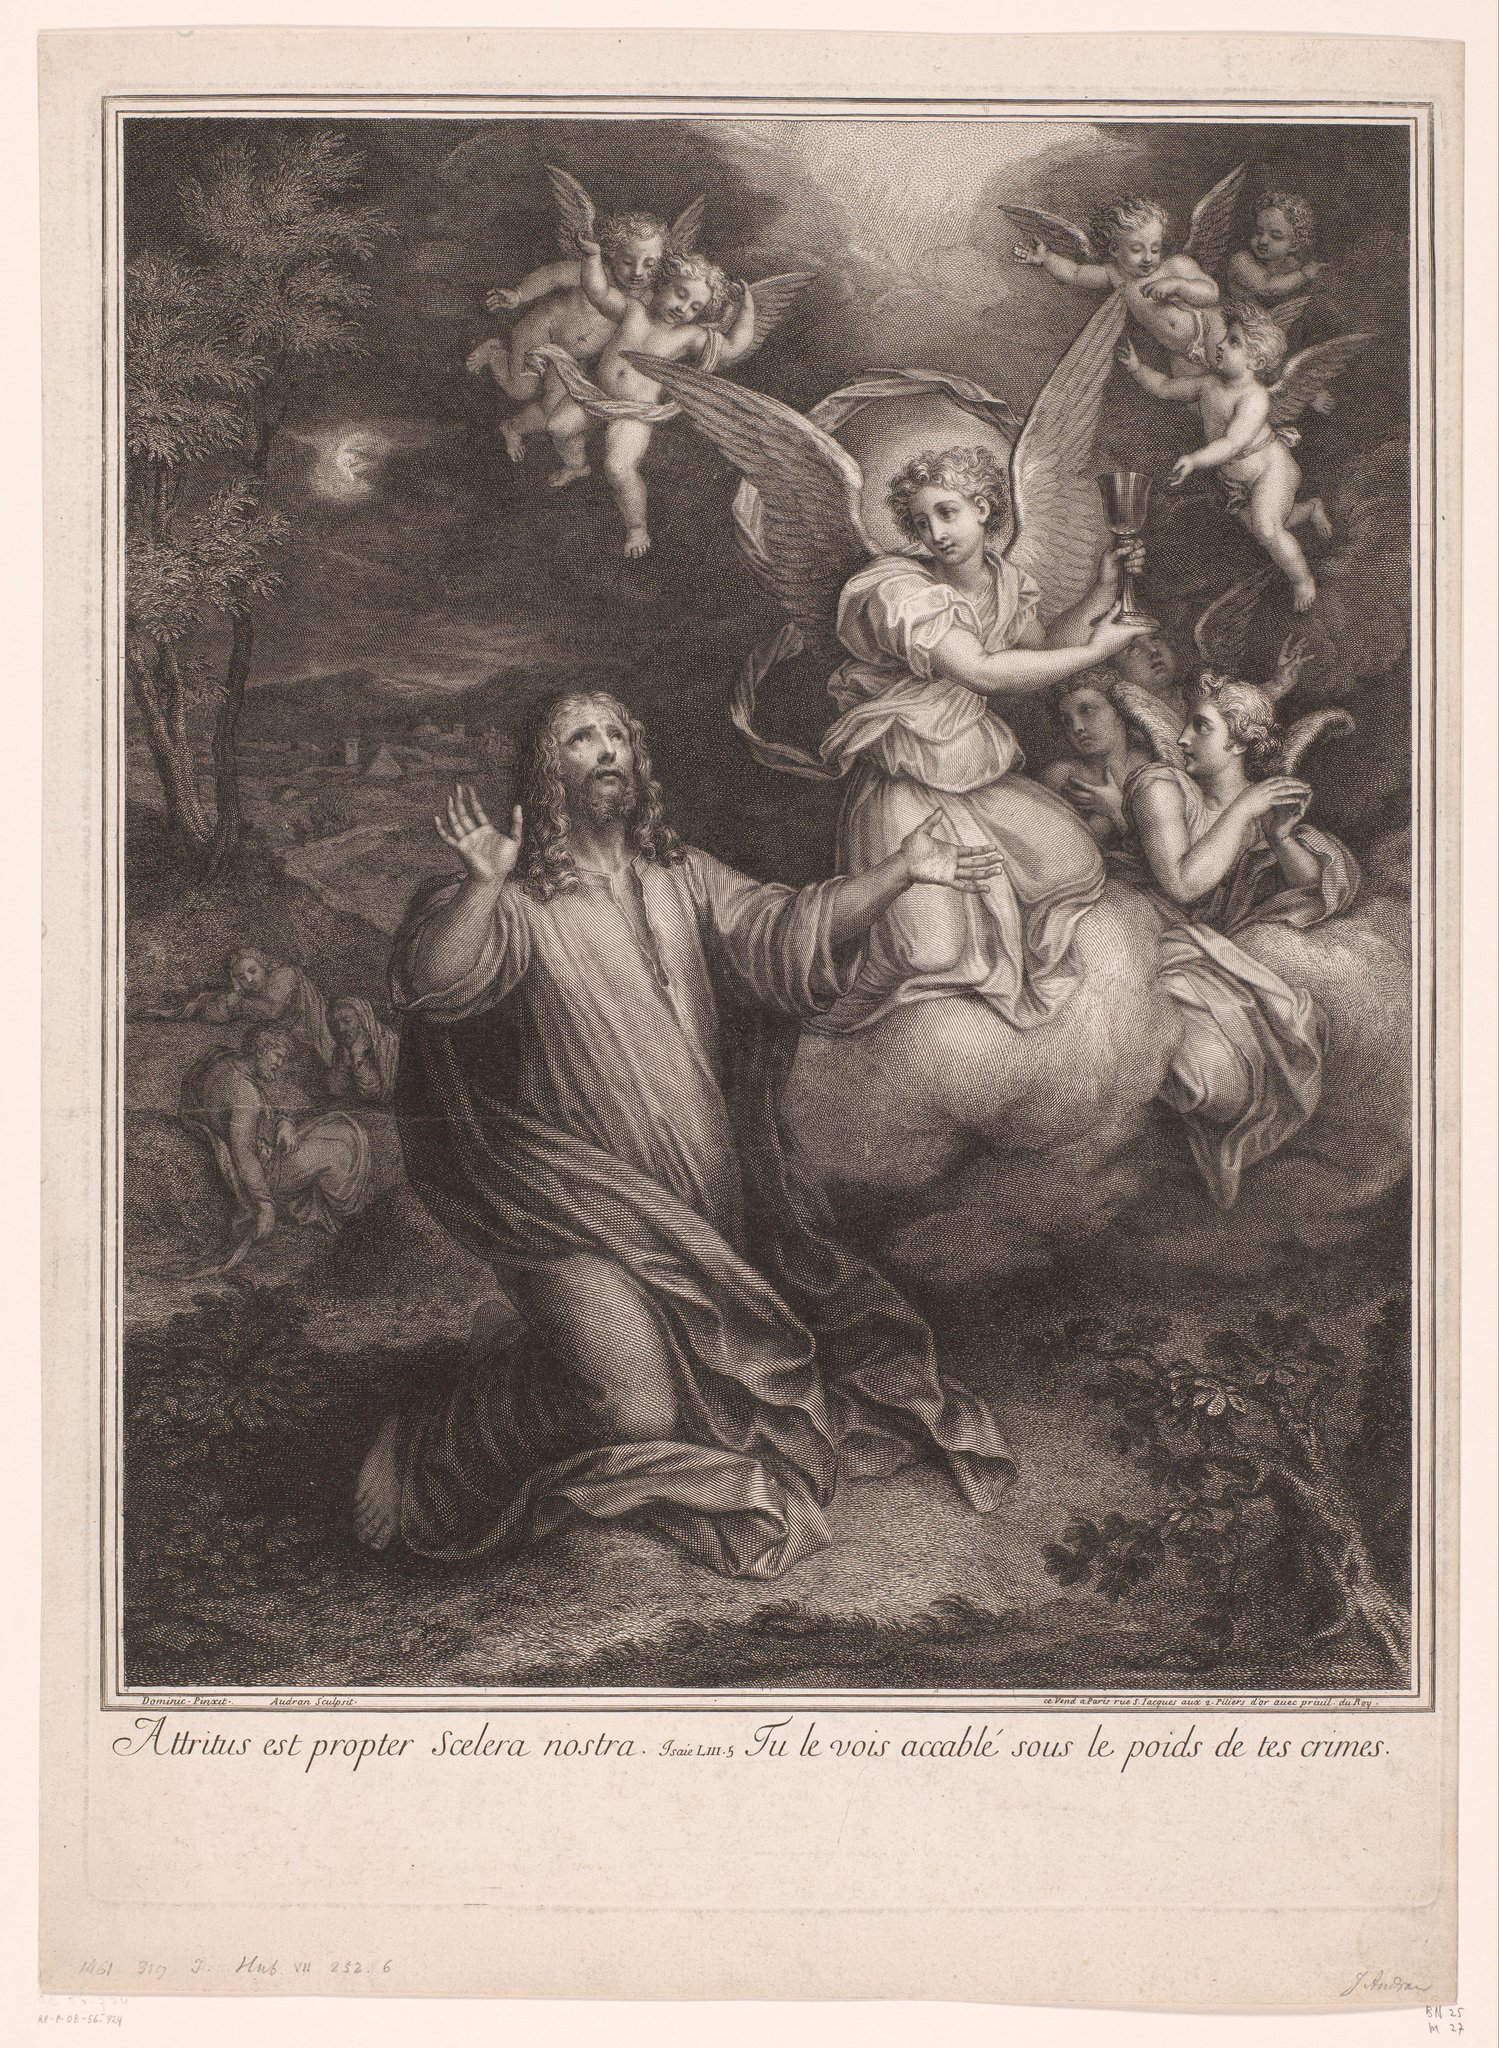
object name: print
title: Christus in de hof van Getsemane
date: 1677-1756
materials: paper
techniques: engraving, etching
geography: france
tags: christ ascends into heaven; apostles (and mary) beneath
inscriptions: collector's mark: Lugt 240